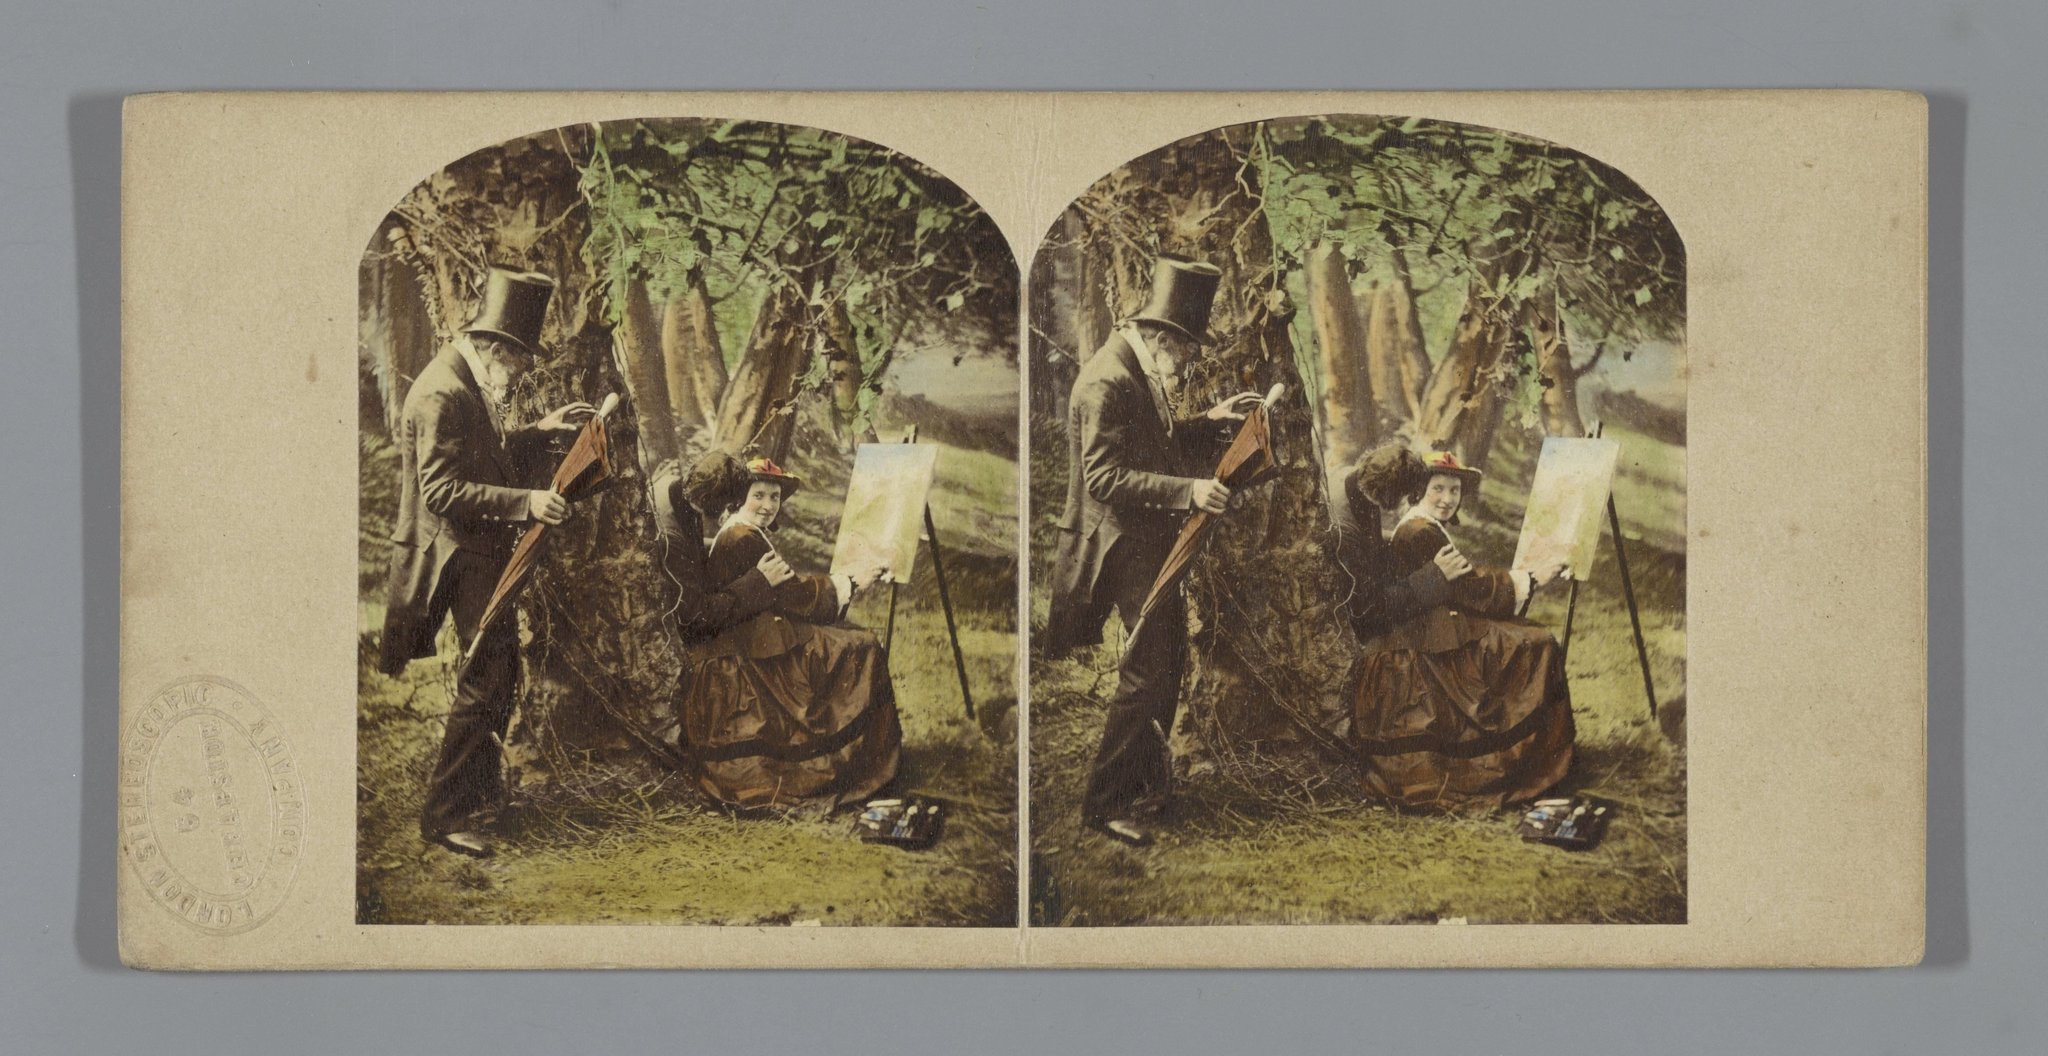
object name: stereograph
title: Tafereel in een bos met twee mannen en een vrouw achter een schildersezel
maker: james elliott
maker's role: publisher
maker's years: 1832-1900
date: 1856-1859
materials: cardboard, paper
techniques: albumen print, hand coloring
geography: london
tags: easel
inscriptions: inscription: ‘Dmjs/ h/ f1,75’, inscription: ‘Entered at Stationers' Hall.’